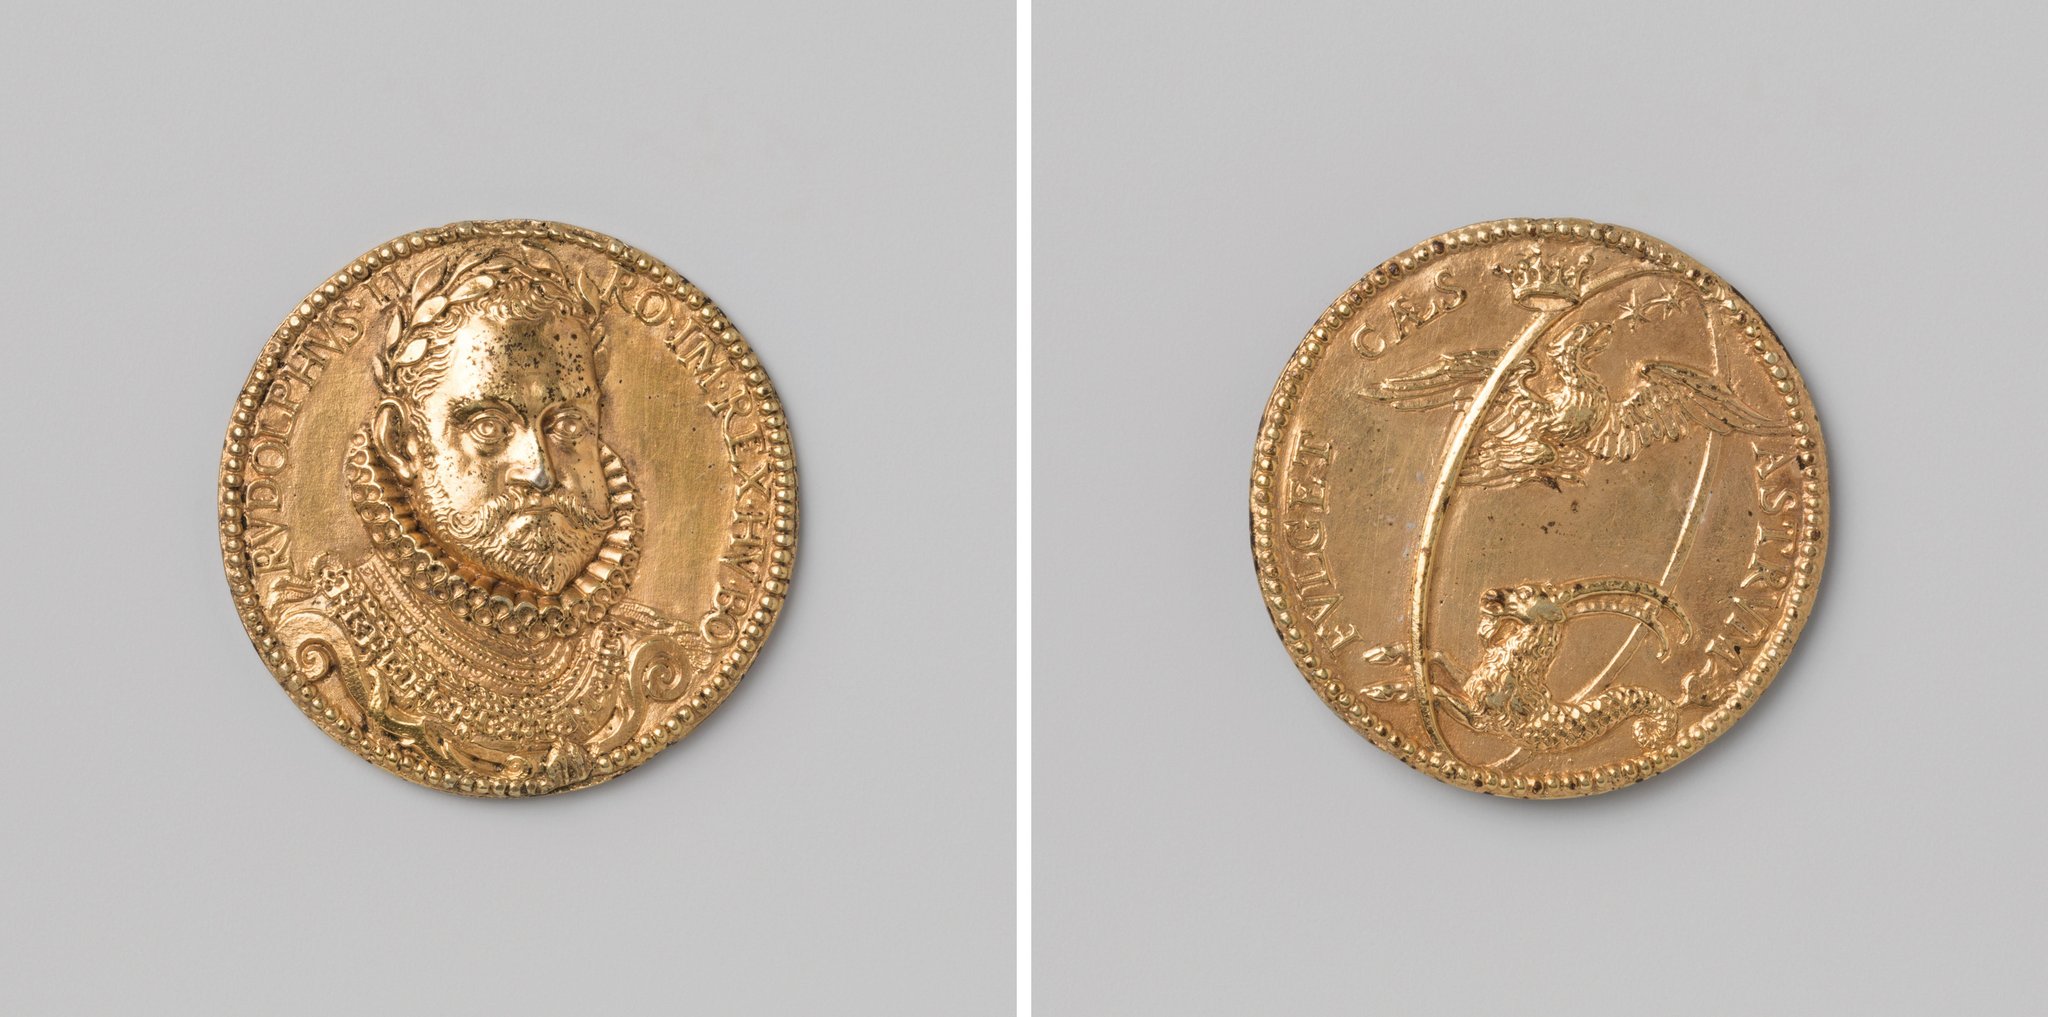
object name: history medal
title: Penning met portret Rudolph II, Duits keizer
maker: paulus willemsz. van vianen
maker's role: draughtsman, jeweler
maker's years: 1570-1614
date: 1603-1608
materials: gold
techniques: casting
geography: prague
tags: vienna, prague, rudolf ii van habsburg (duits keizer), germany, austria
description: Penning goud met portret Rudolph II: Voorzijde: borstbeeld van voren en van rechts gezien, met lauwerkrans, gepijpte kraag, harnas en ordeteken van het Gulden Vlies. Randschrift: RUDOLPHUS II RO(manorum) IM(perator) REX HU(ngariae) BO(emiae). Parelrand. Keerzijde: Zodiak, beneden steenbok, boven gekroonde adelaar vliegend naar twee sterren. Randschrift: FULGET CAES (areum) ASTRUM.